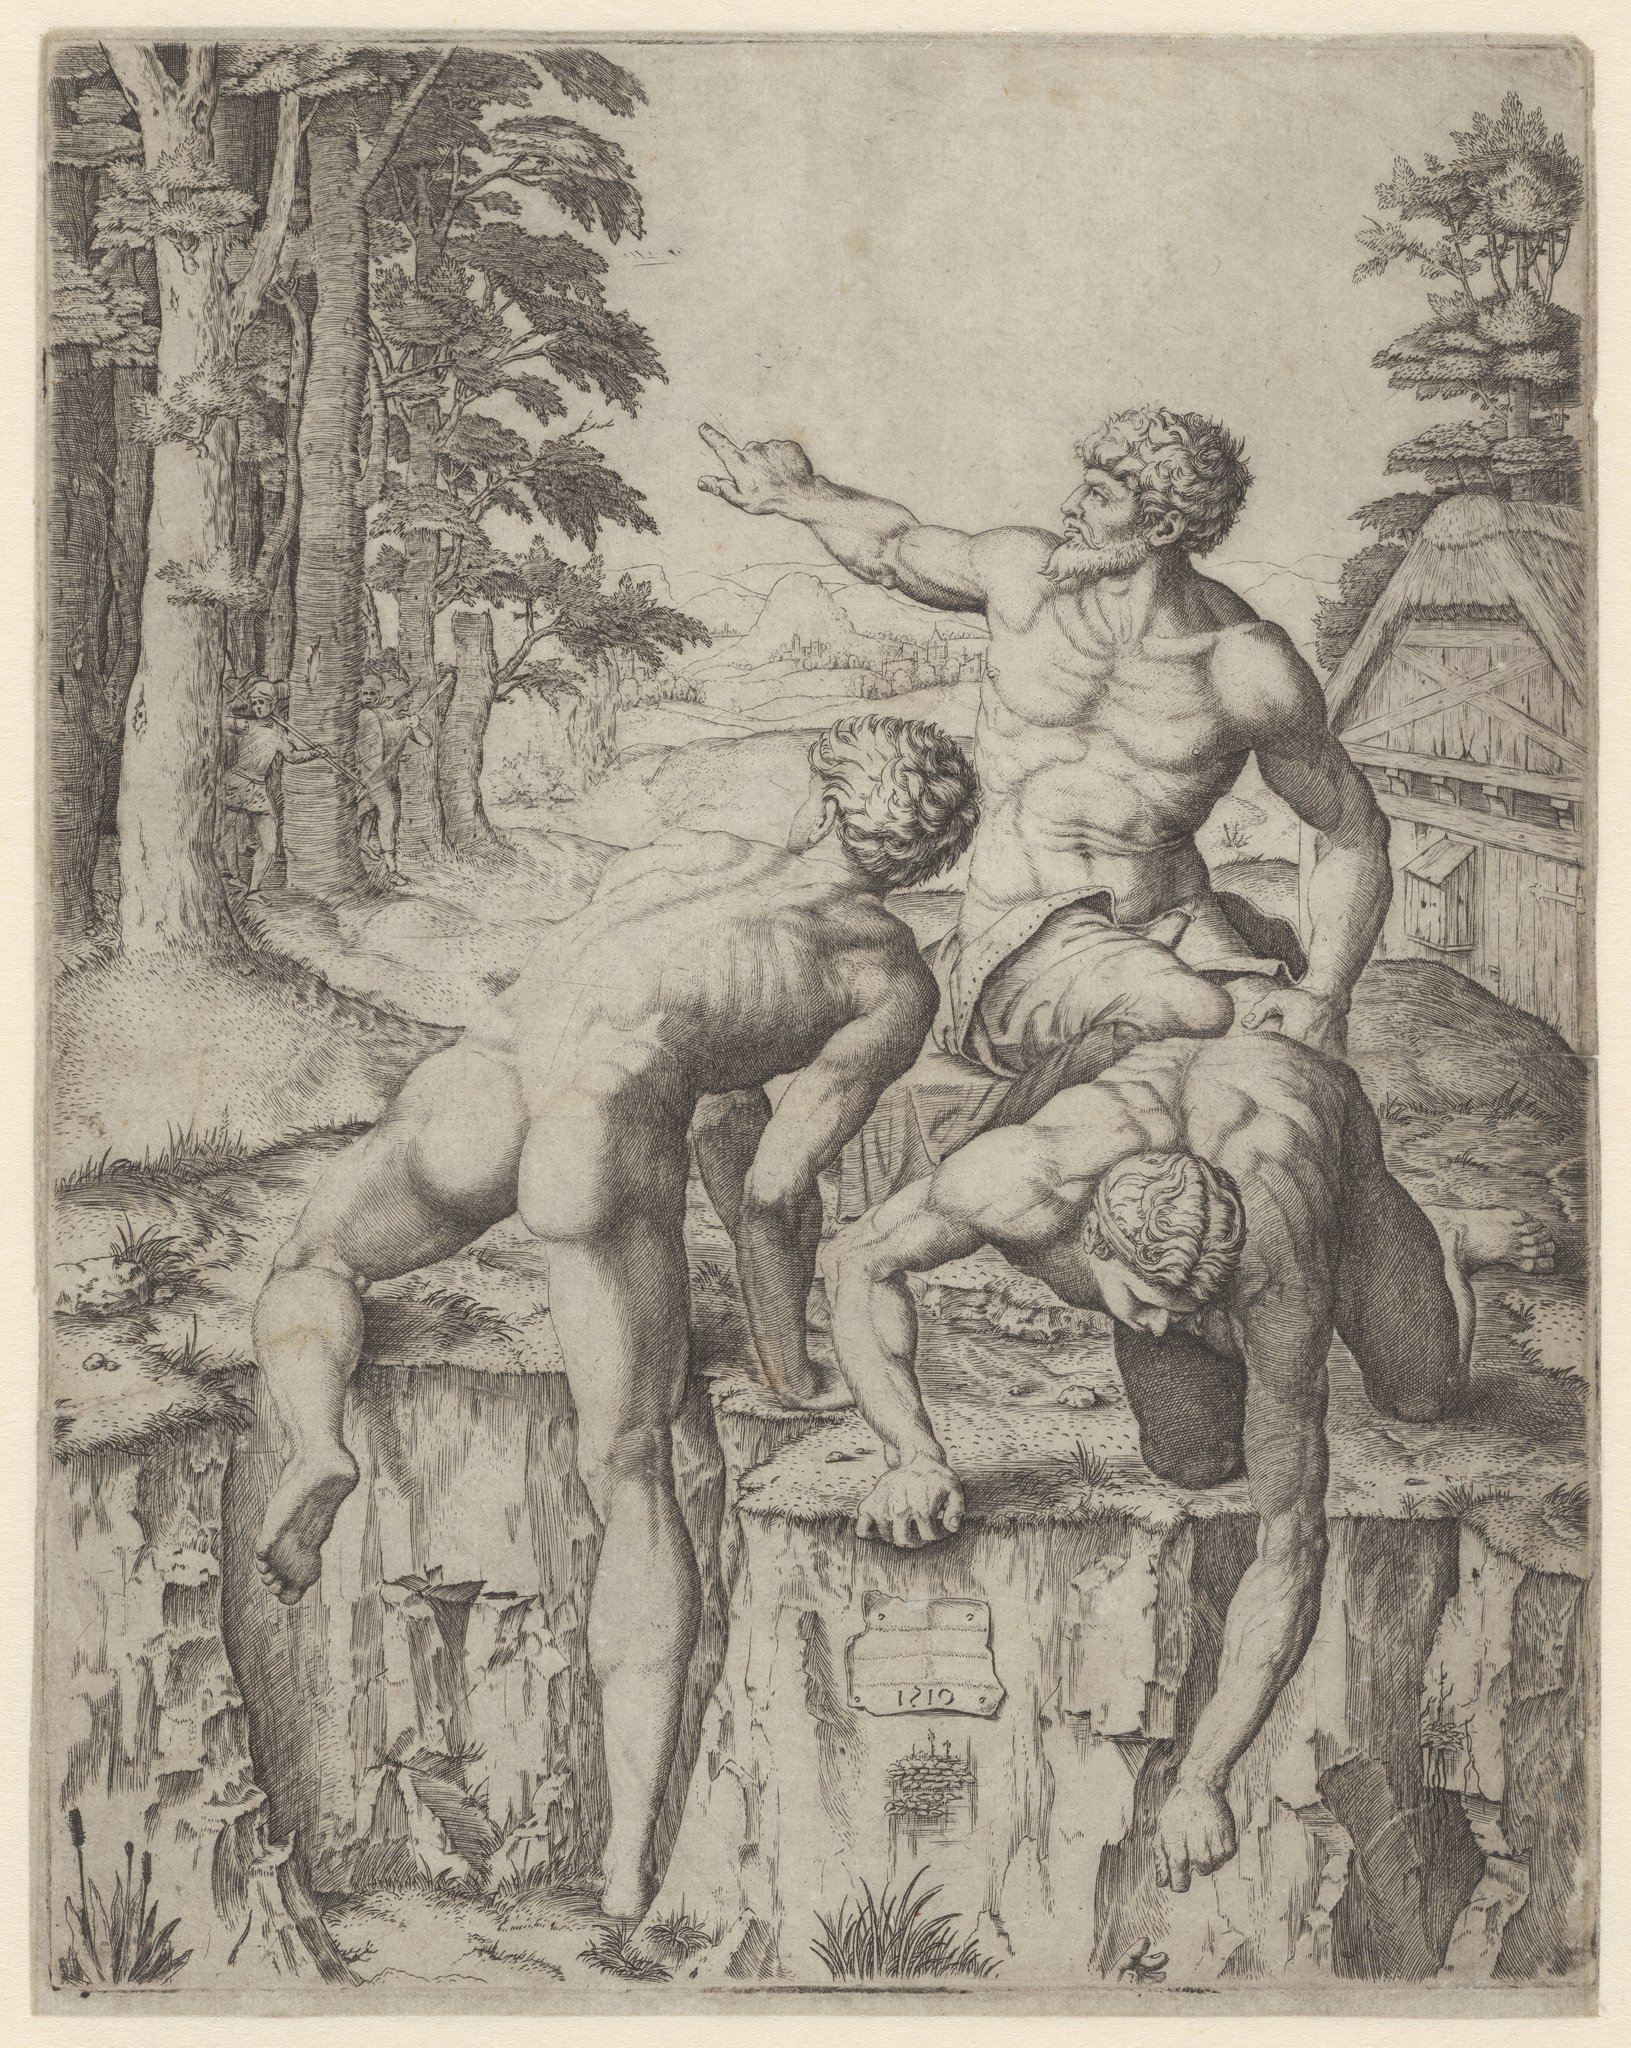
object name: print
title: Drie naakte mannen in landschap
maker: marcantonio raimondi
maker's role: print maker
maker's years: 1470-1534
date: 1510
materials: paper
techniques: engraving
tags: the (nude) human figure; 'corpo humano' (ripa), male sex; man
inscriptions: date: ‘1510’, collector's mark: Lugt 240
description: De drie naakte mannenfiguren zijn gebaseerd op de cartons voor de Slag bij Cascina van Michelangelo. Raimondi heeft een eigen compositie gemaakt en de figuren niet als groep gekopieerd. Het landschap waarin de figuren zijn geplaatst, is ontleend aan een prent van Lucas van Leyden, getiteld Mohammed en de monnik Sergius (Shoemaker 1981, p. 90-93).